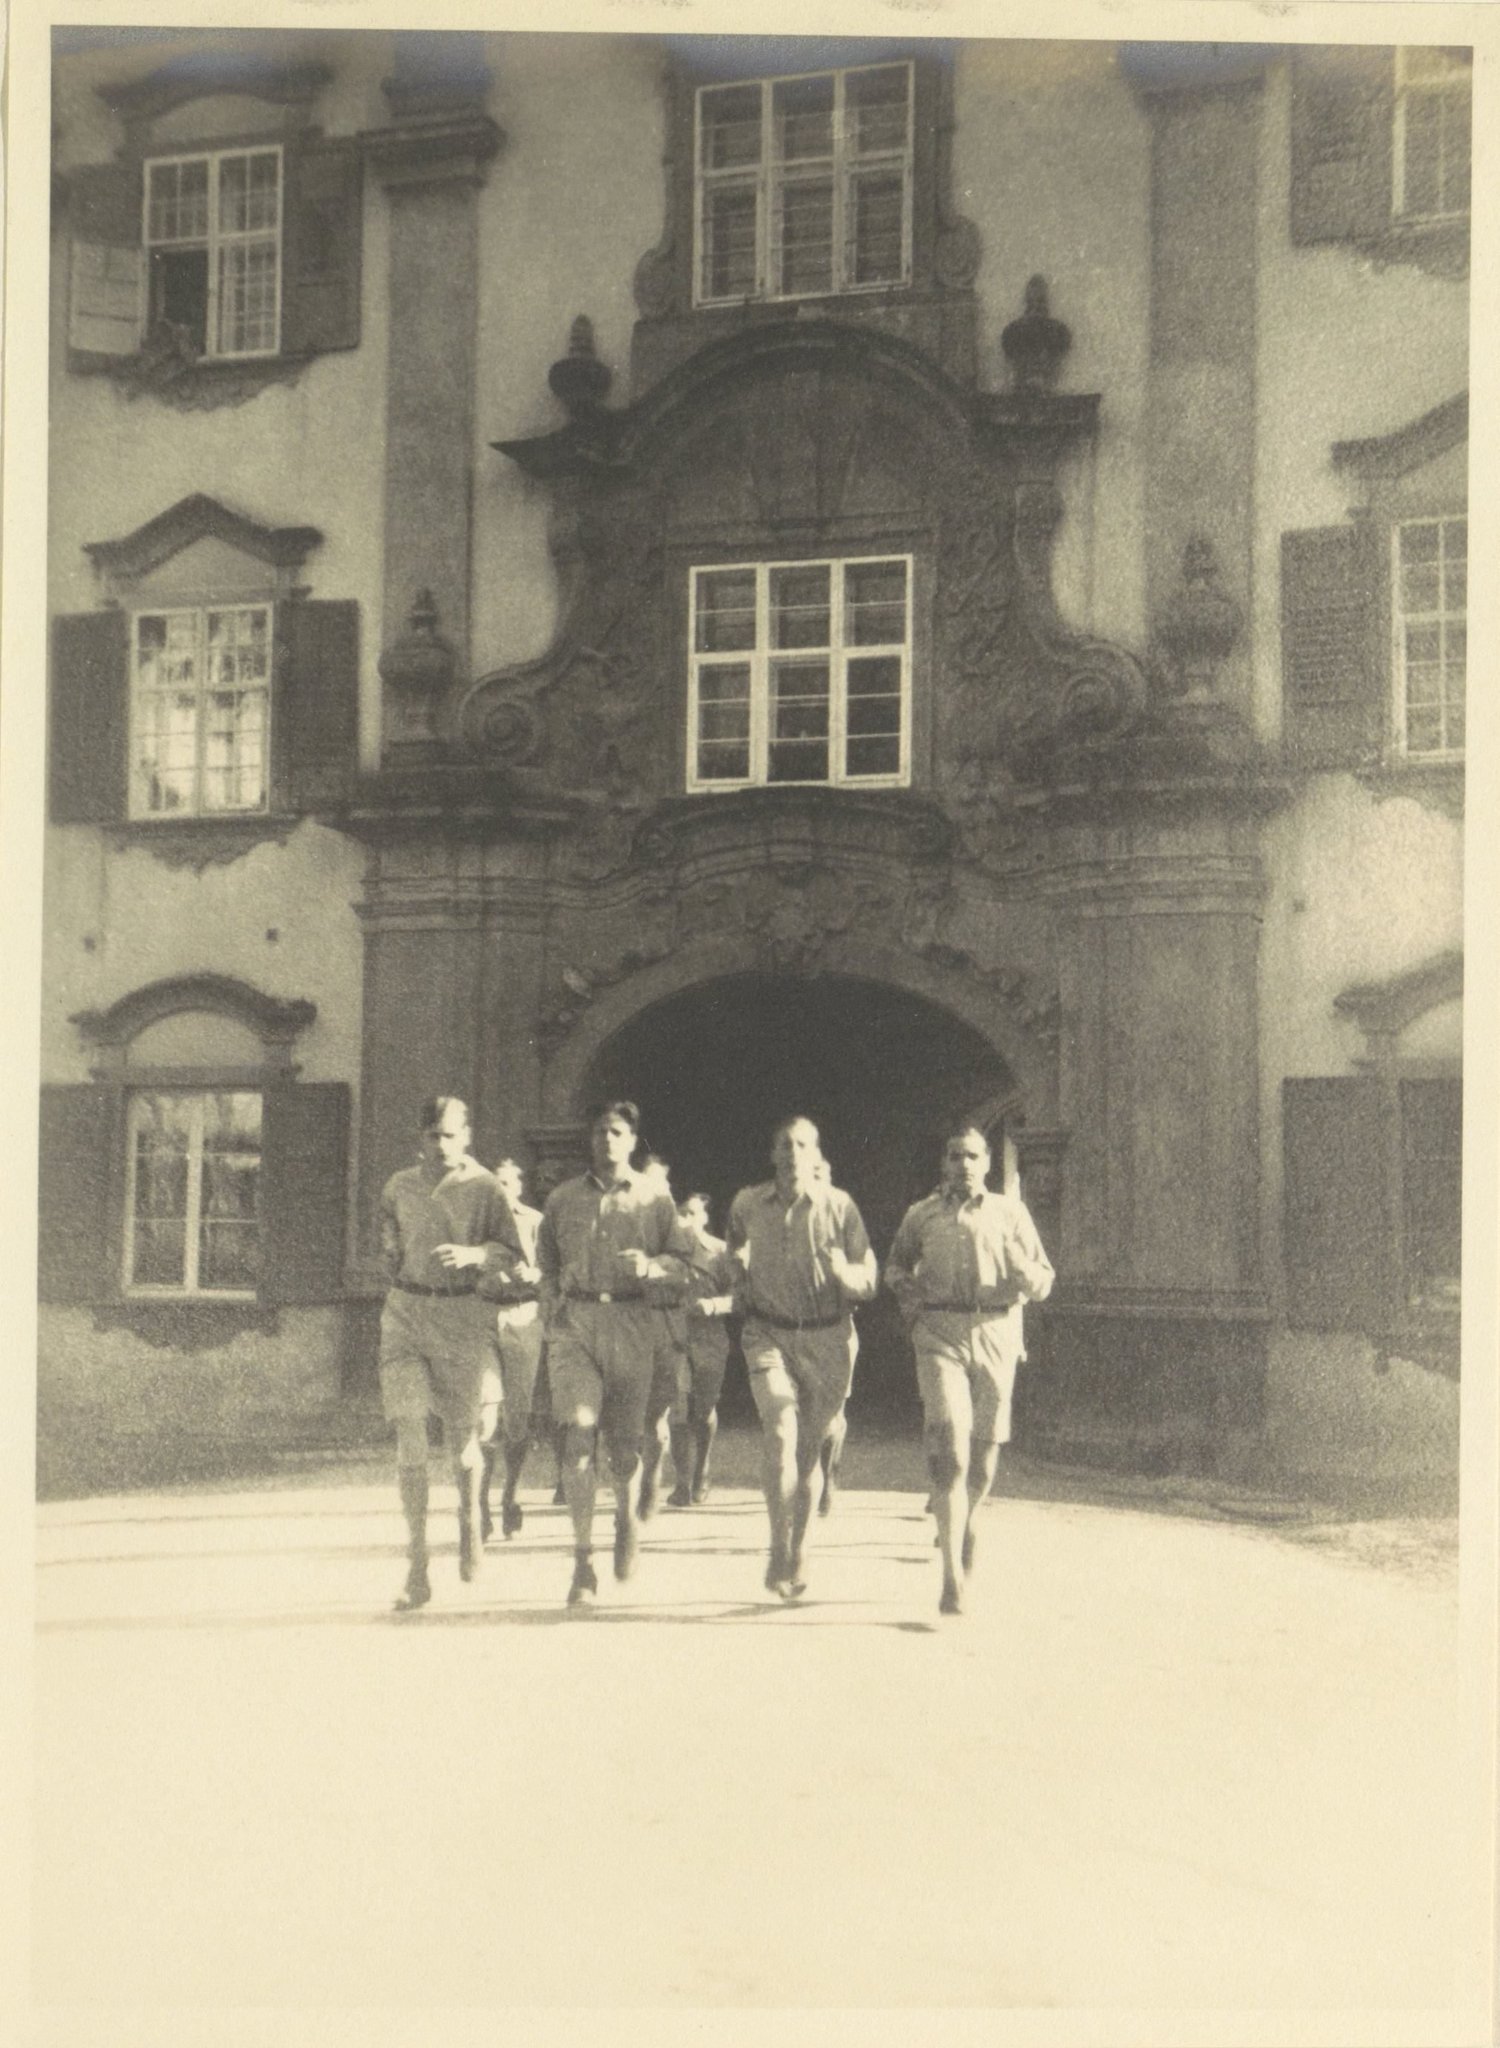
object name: photograph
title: Rennende leerlingen van Schule Schloss Salem bij een groepsdiscipline-oefening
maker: Anonymous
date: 1929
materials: photographic support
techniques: gelatin silver print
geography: salem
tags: youth, adolescent, running, education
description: Onderdeel van Fotoalbum van Schule Schloss Salem.